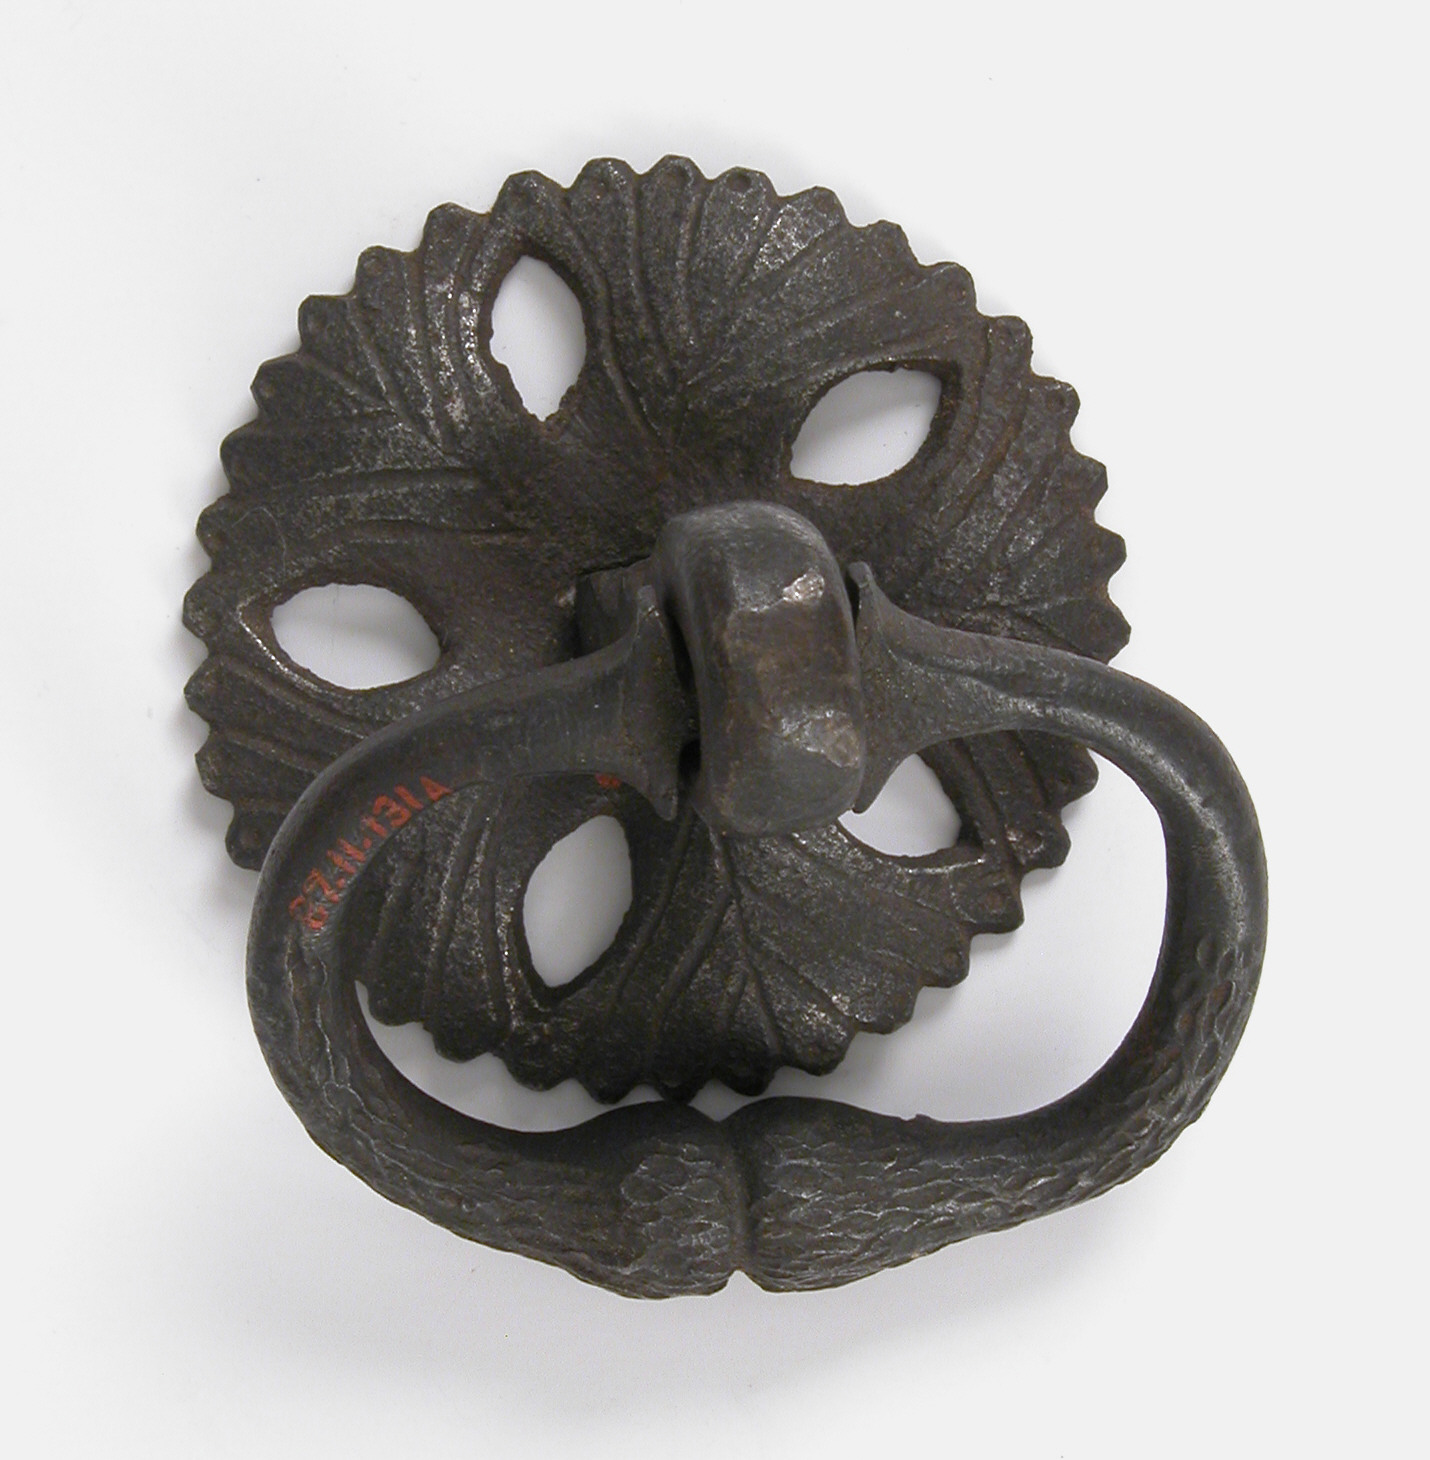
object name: drawer handle and plate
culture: german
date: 1460-1520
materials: iron